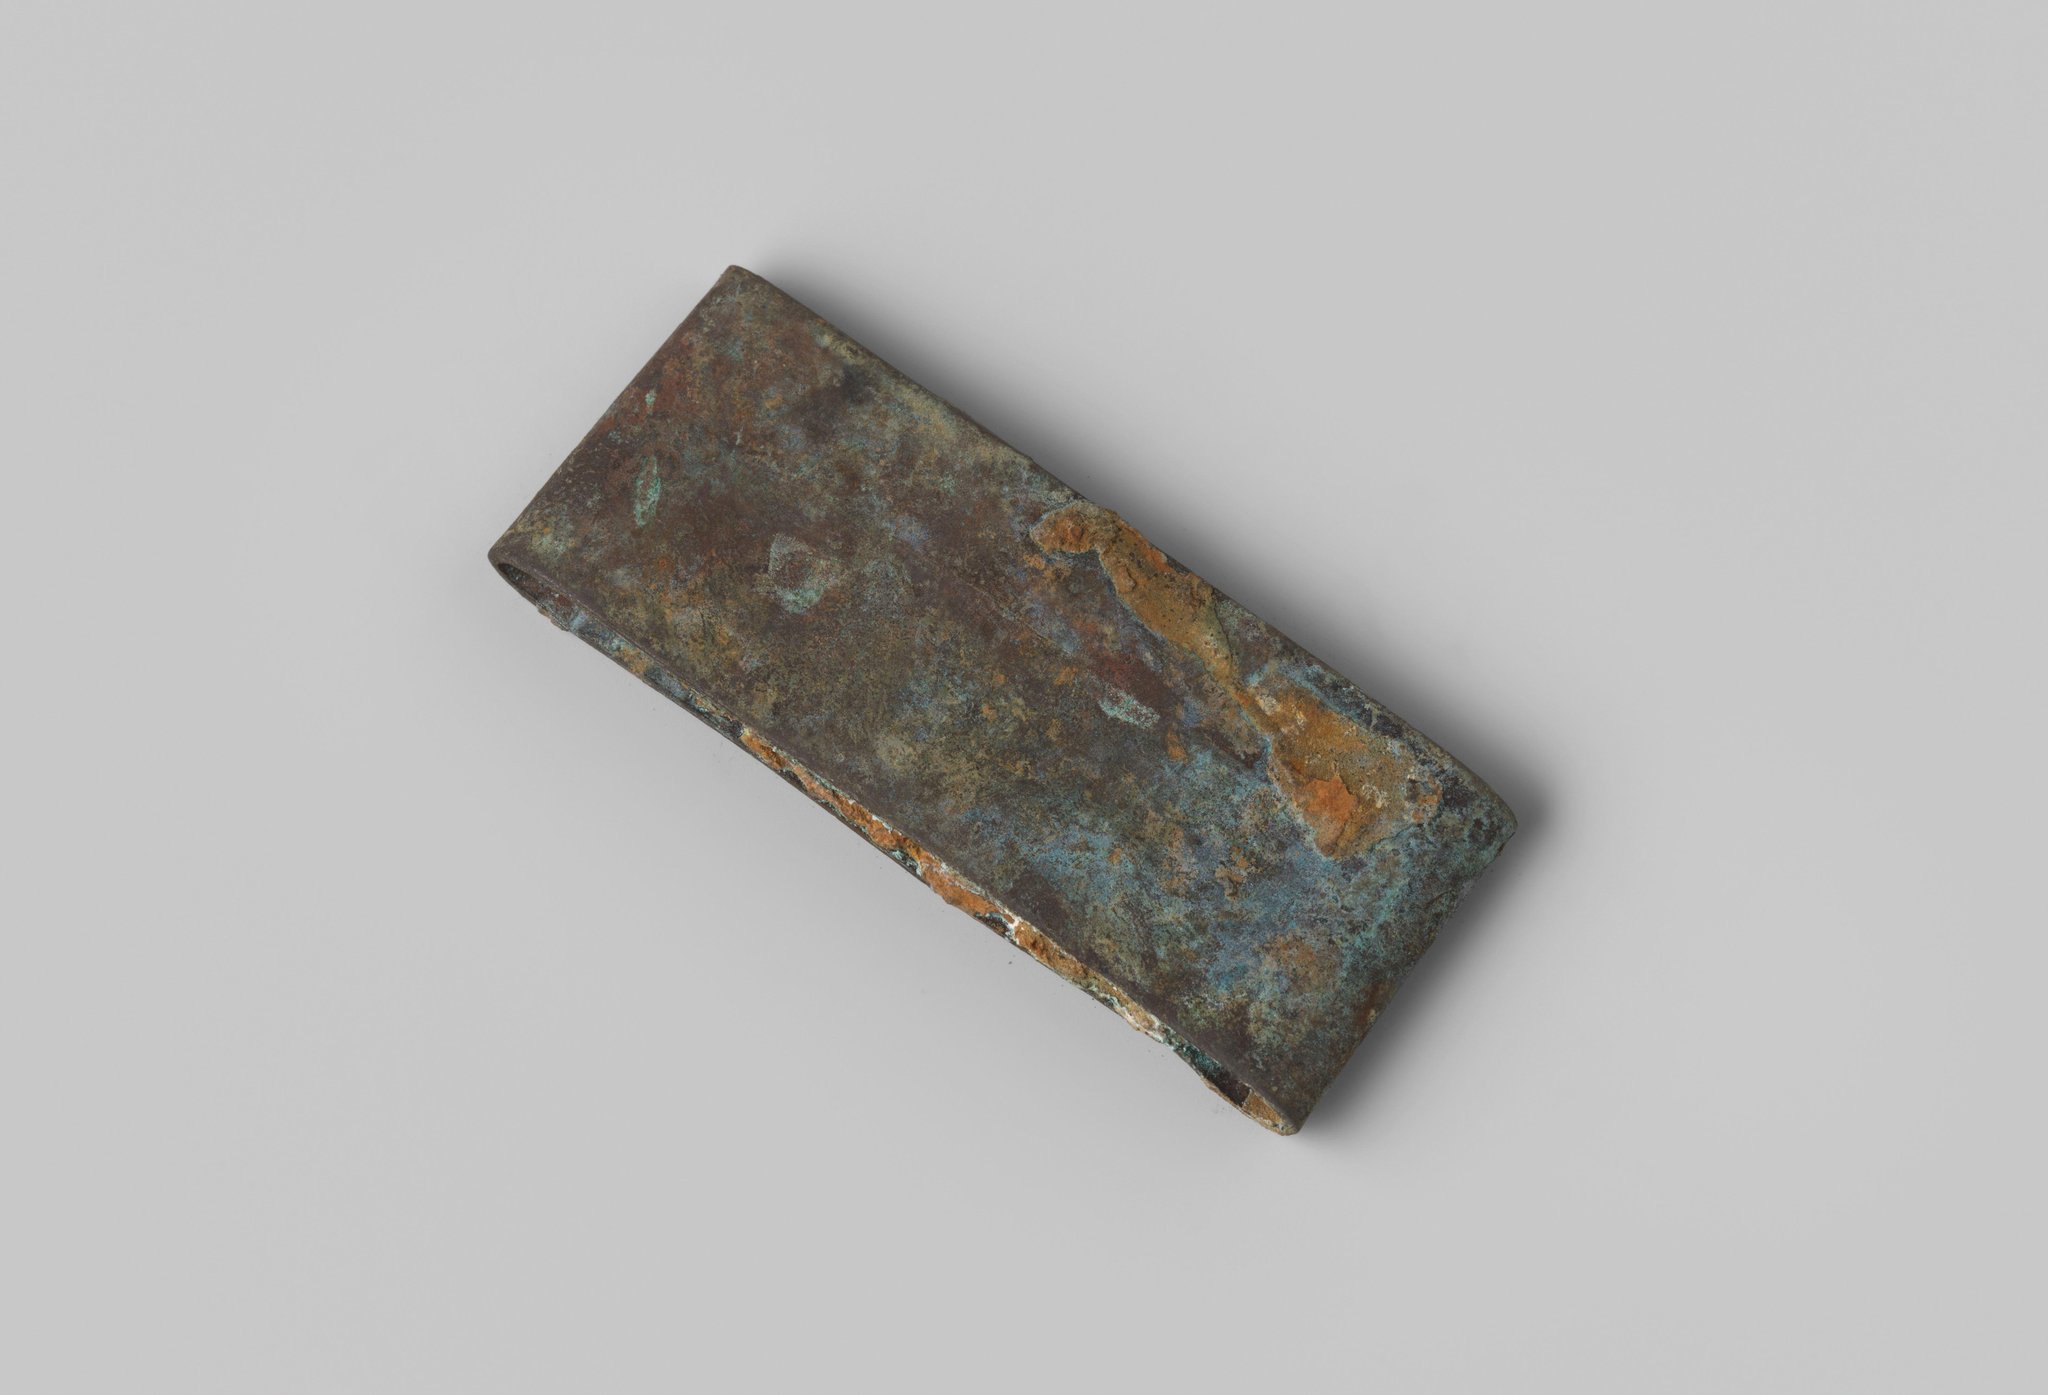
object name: firehose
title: Fragment van brandslangring uit het wrak van de Oost-Indiëvaarder Hollandia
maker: Anonymous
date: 1700-1743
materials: copper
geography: netherlands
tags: verenigde oostindische compagnie, hollandia (schip), annet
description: Fire engine, firehose; fragment, id. NG-1975-20-H-1271-a, squashed.